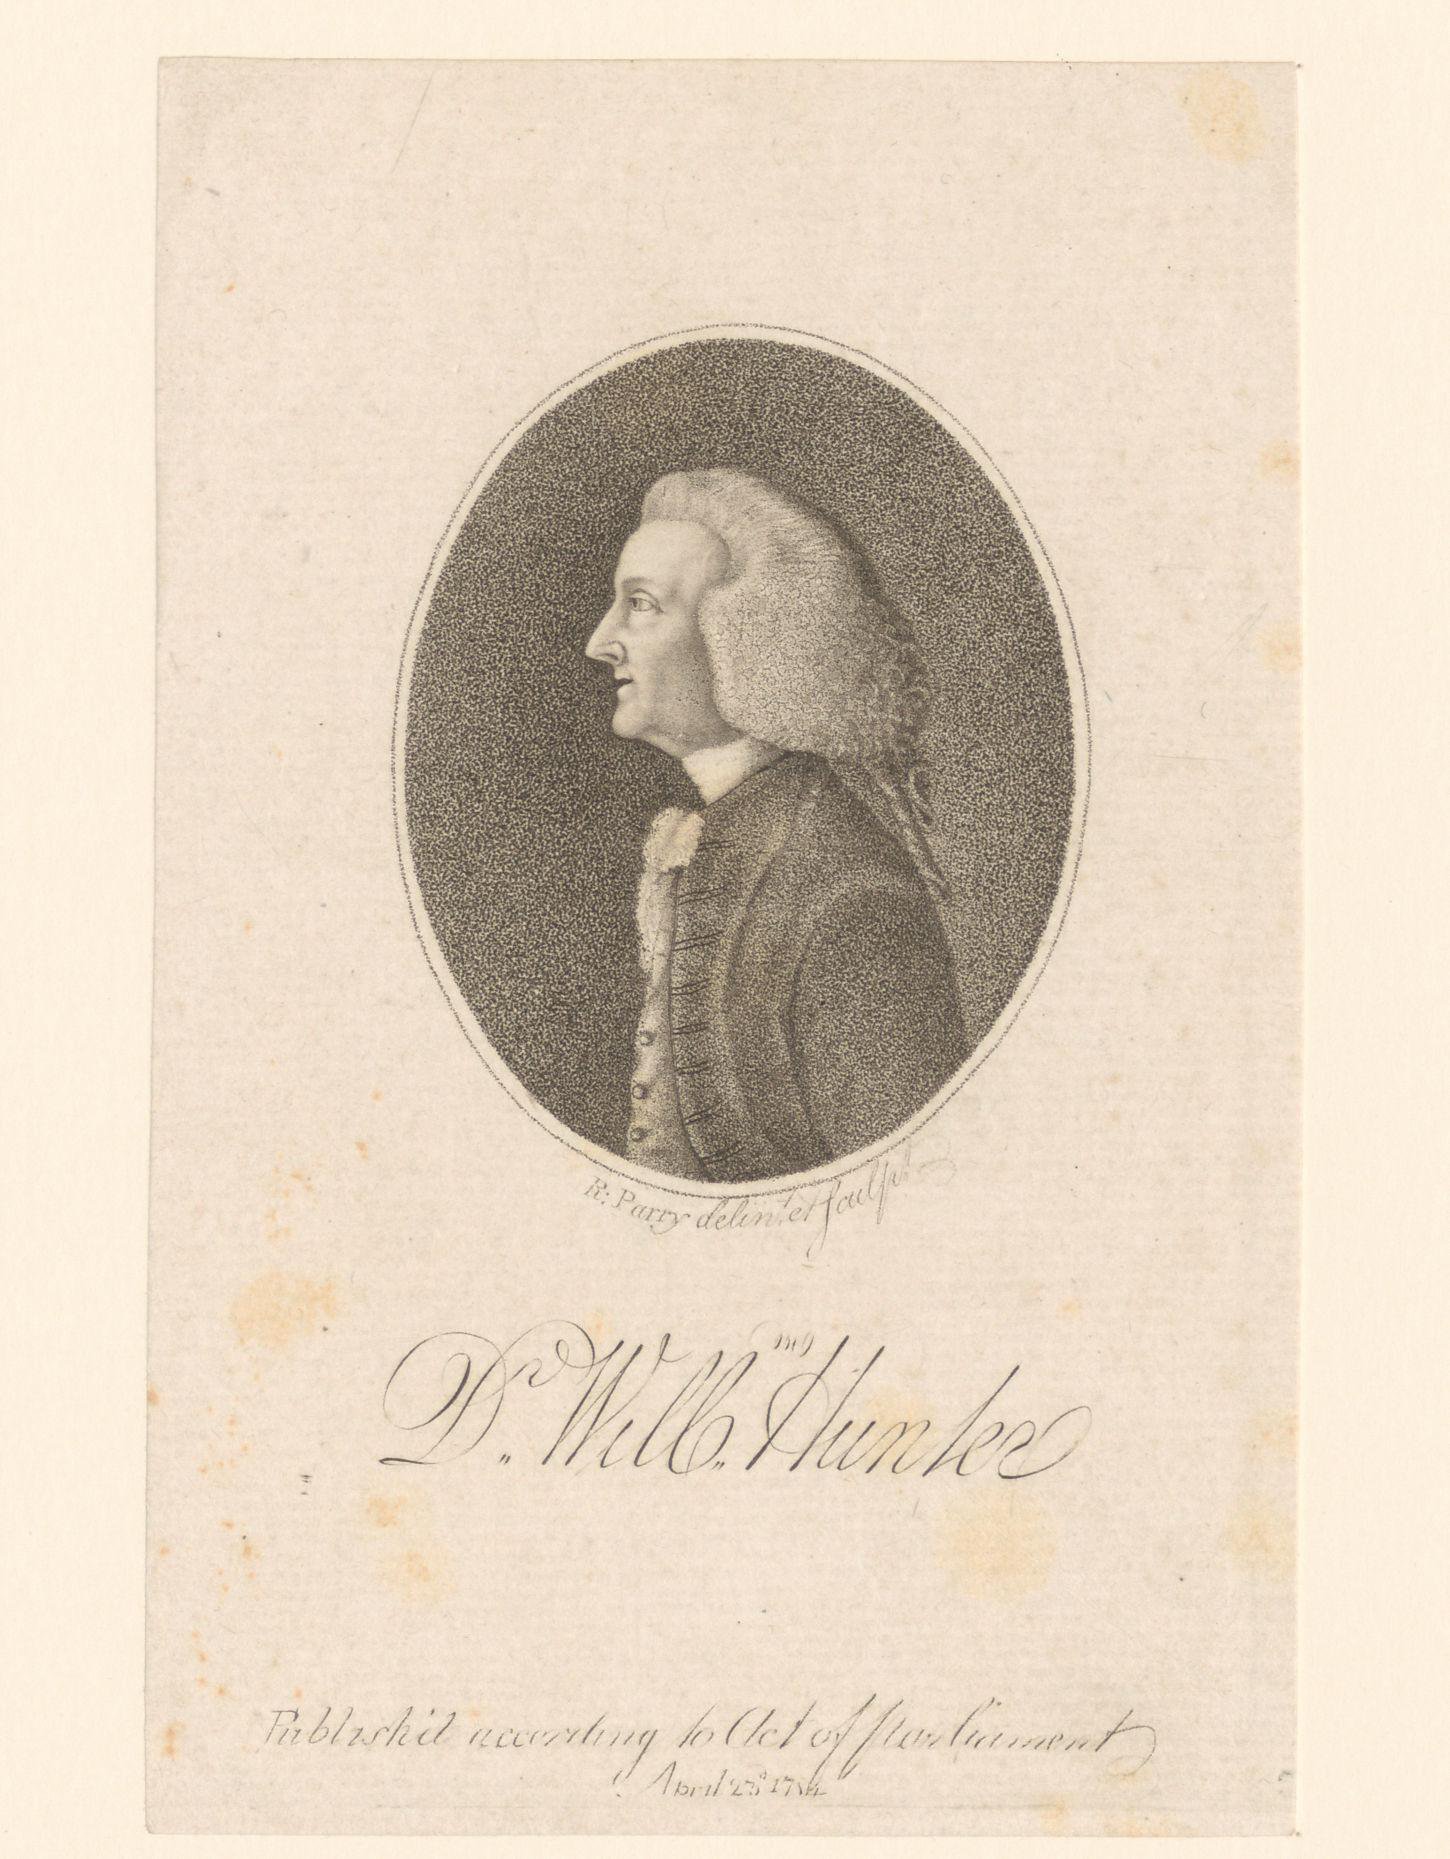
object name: print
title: Dr. Will. Hunter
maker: r. parry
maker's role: print maker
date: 1704-1784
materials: paper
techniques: engraving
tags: historical persons, physician, doctor (+ portrait of scholar, scientist)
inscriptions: collector's mark: Lugt 2228